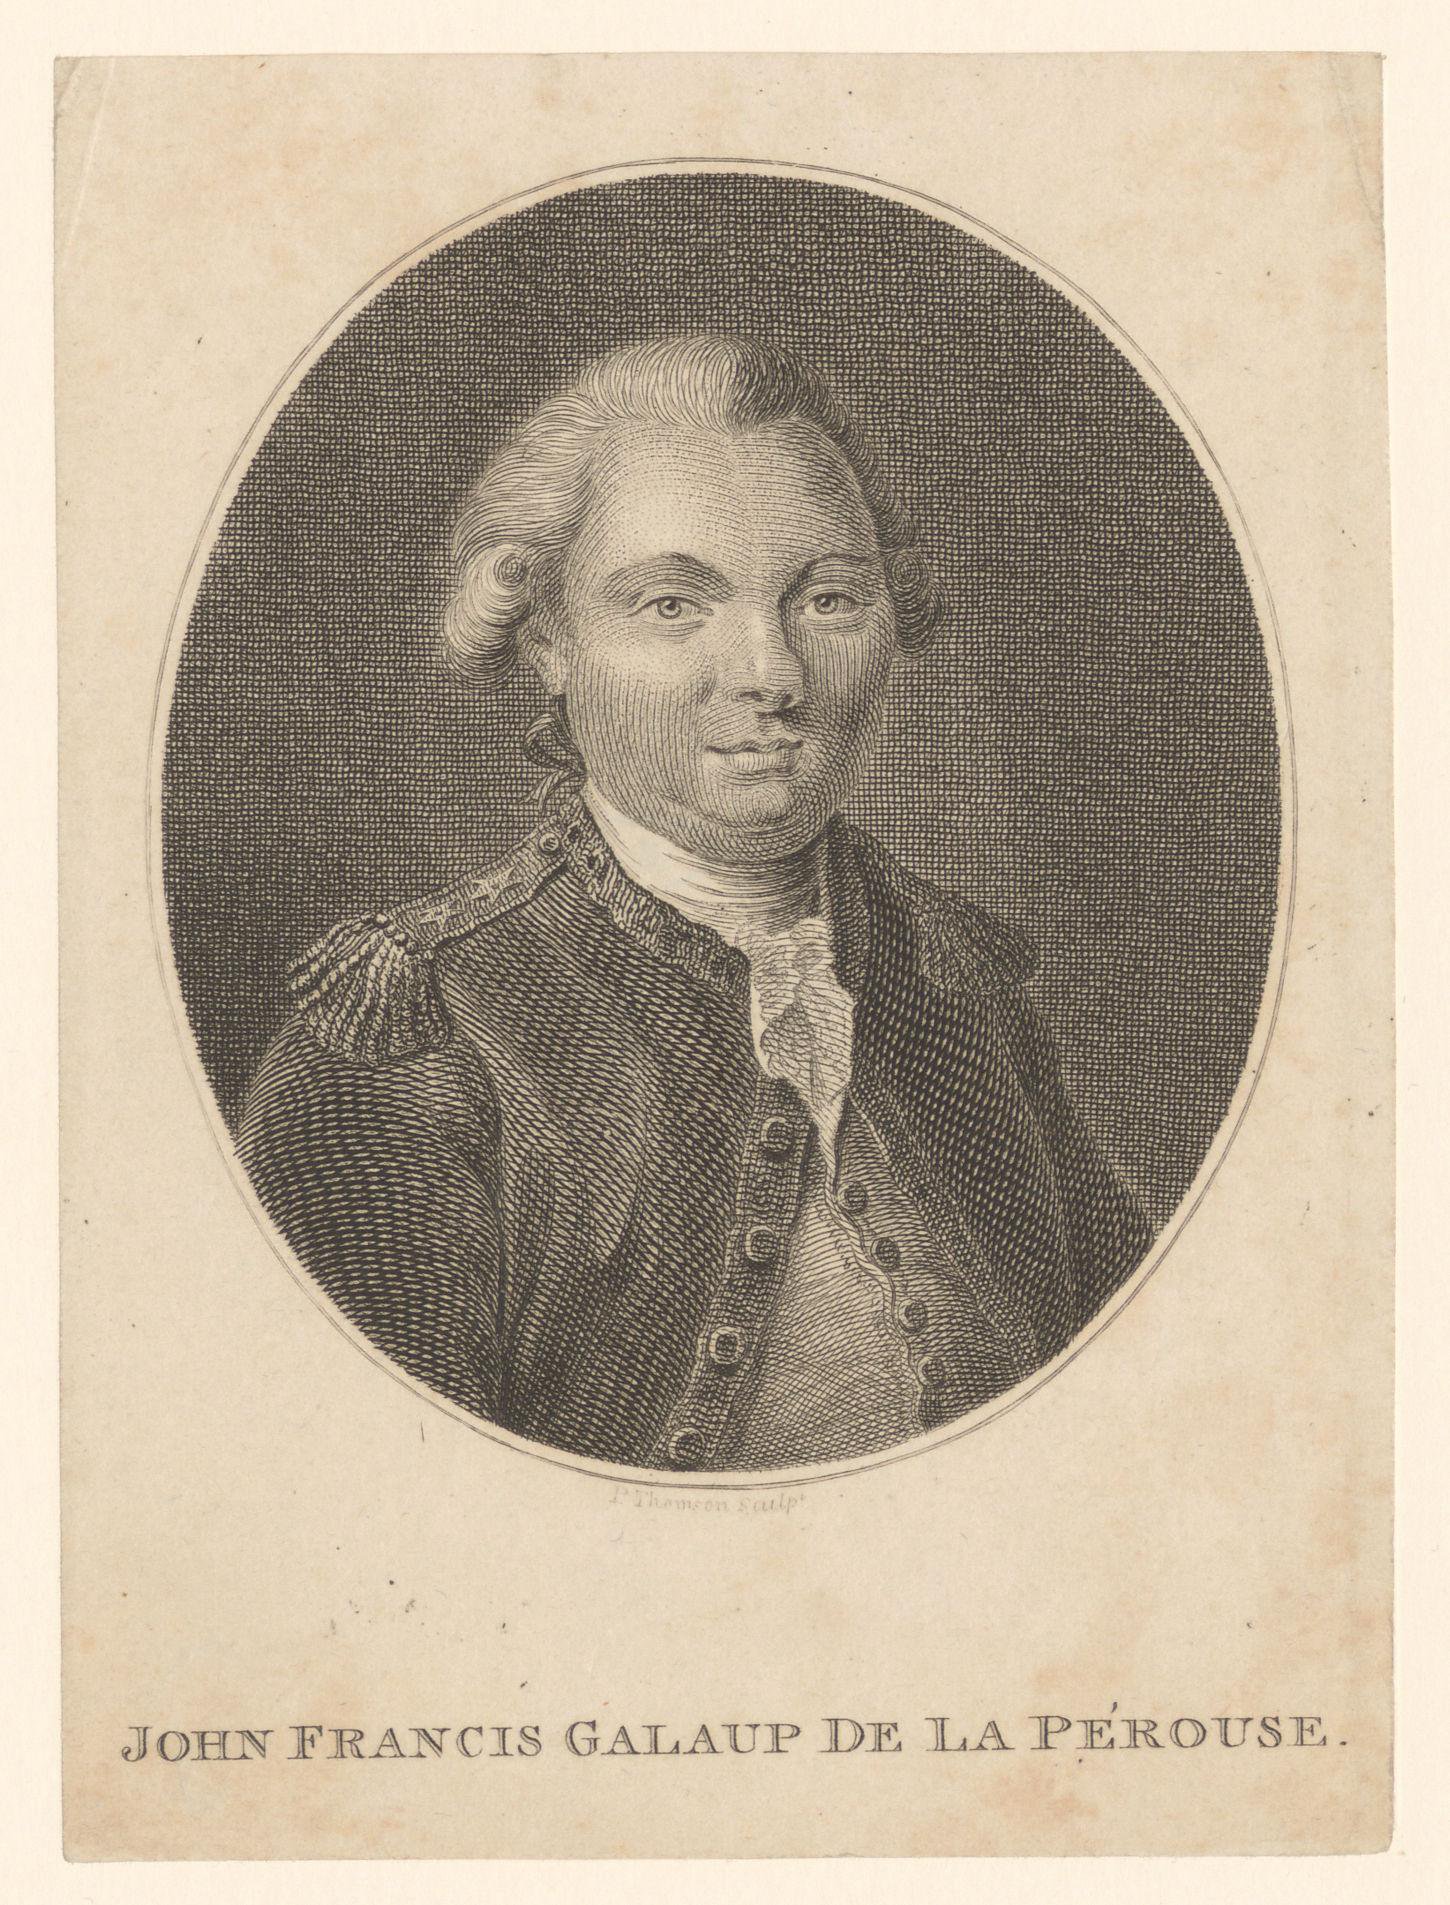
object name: print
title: John Francis Galaup de la Pérouse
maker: paton thomson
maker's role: print maker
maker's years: 1750-1821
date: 1765-1821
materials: paper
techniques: engraving, etching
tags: naval officer, explorer (+ portrait of scholar, scientist), historical persons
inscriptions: collector's mark: Lugt 2228